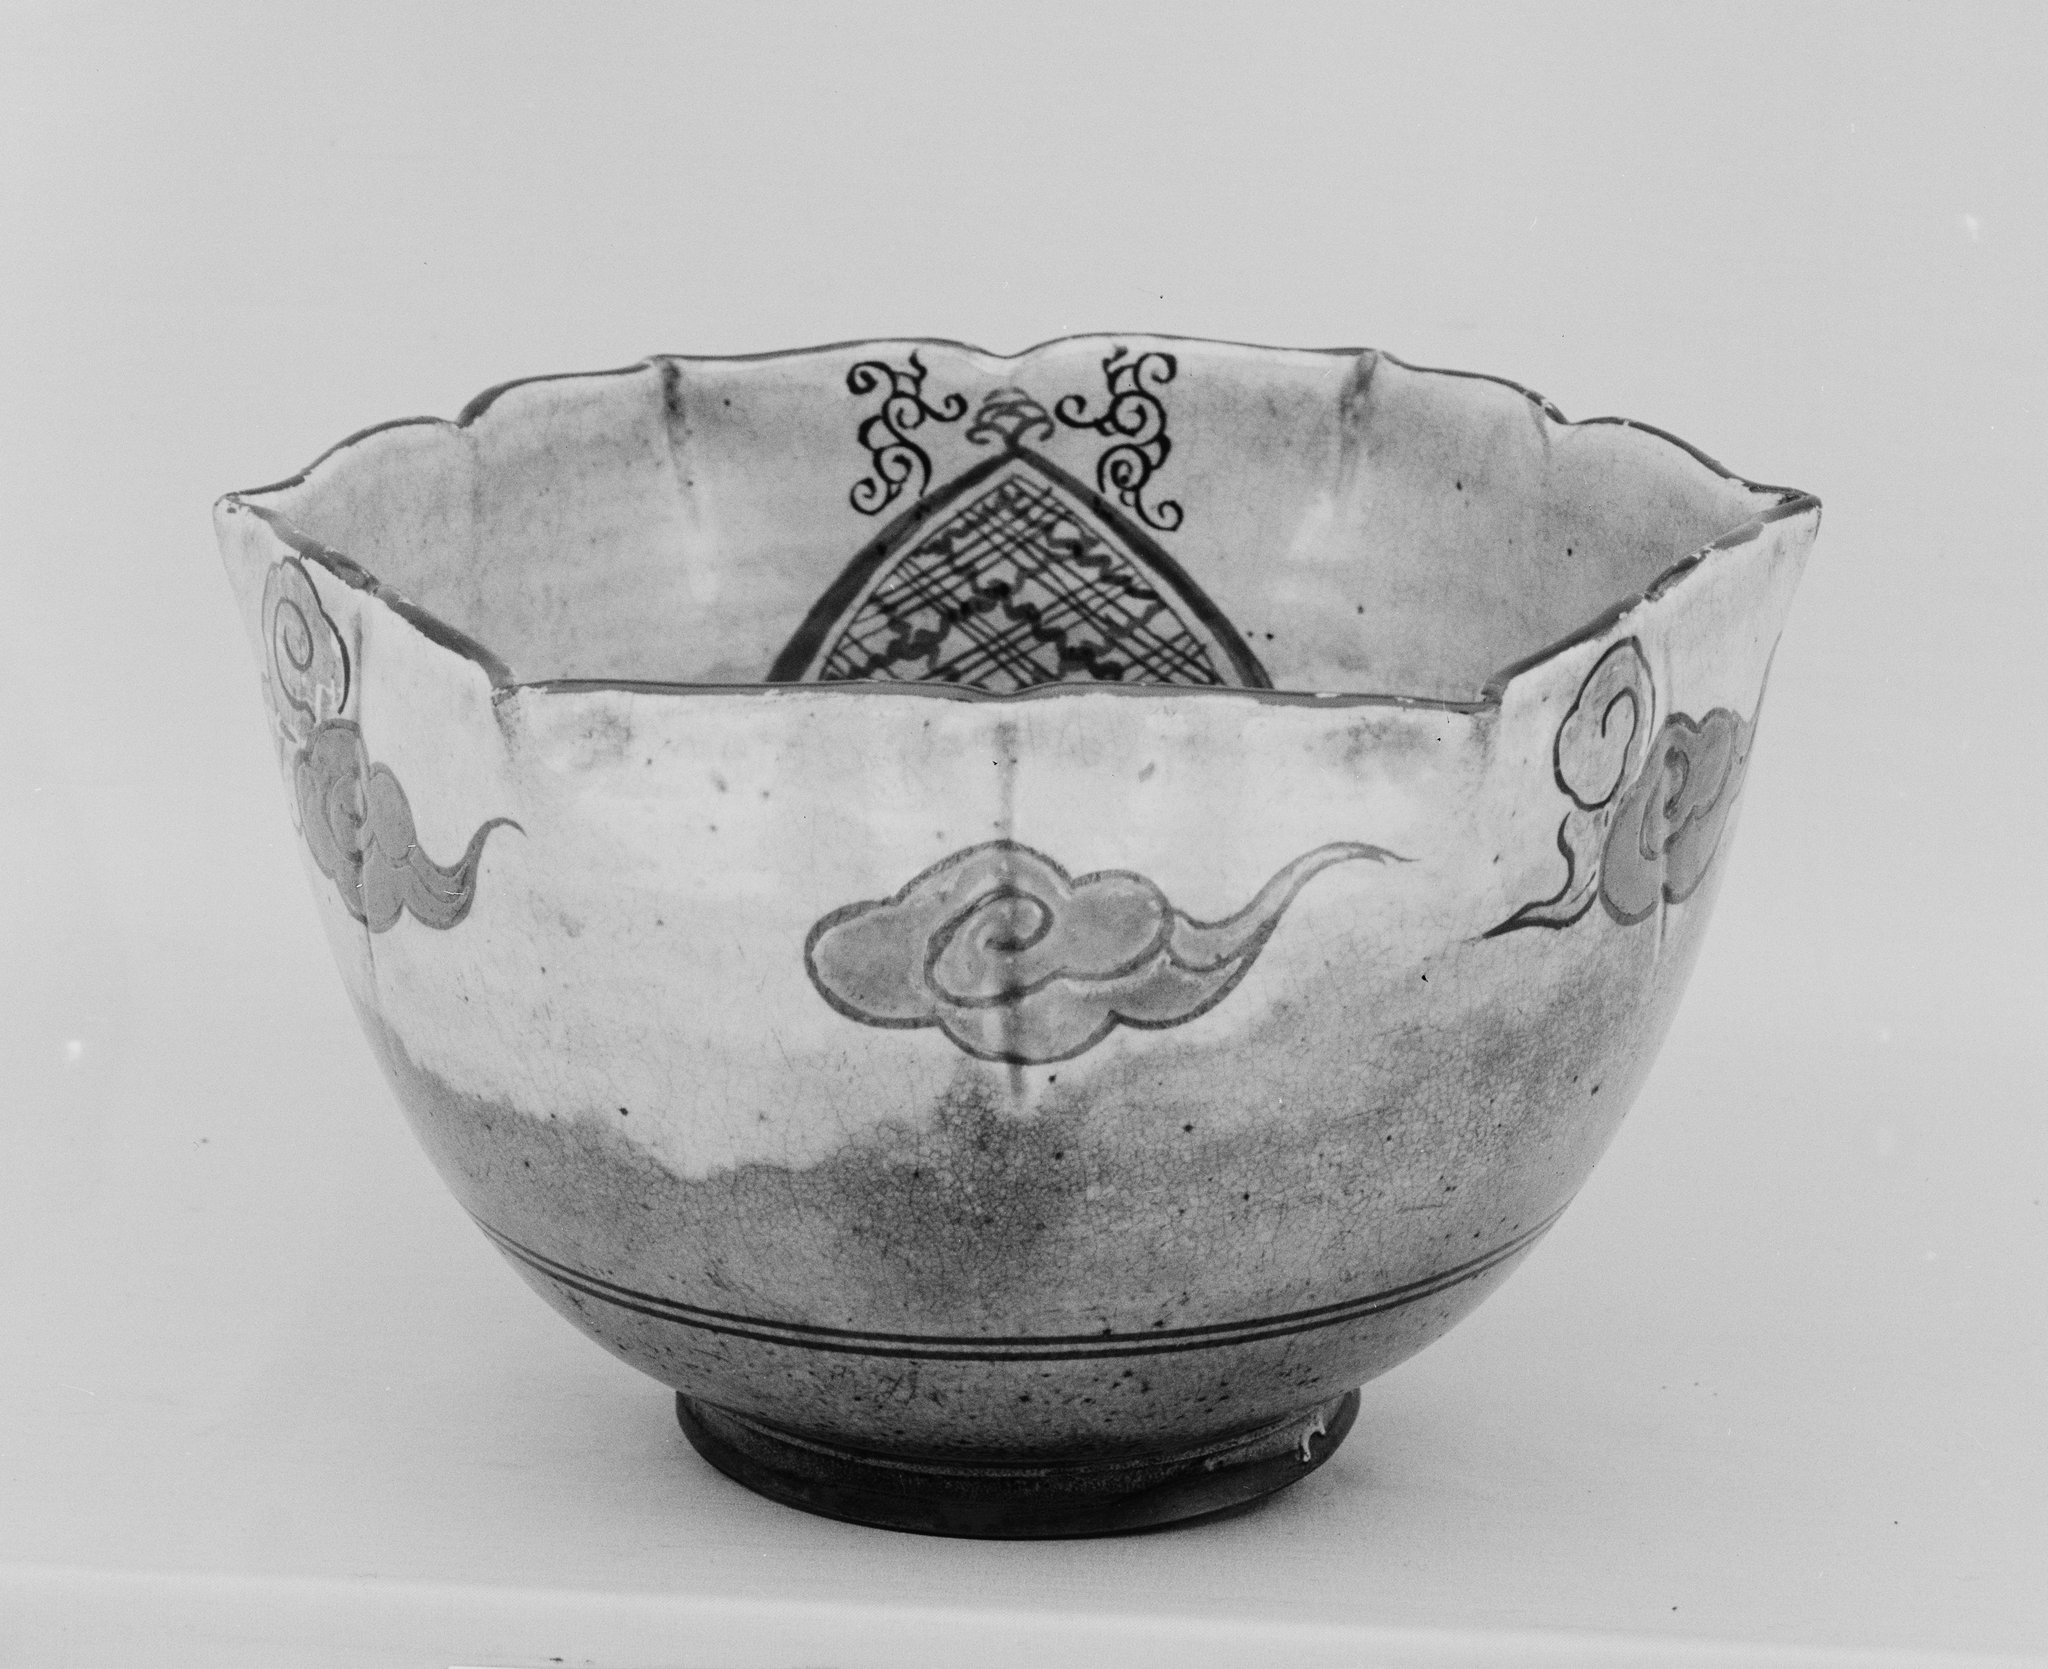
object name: bowl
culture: japanese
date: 1801-1900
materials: clay, enamel, glaze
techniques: polychrome